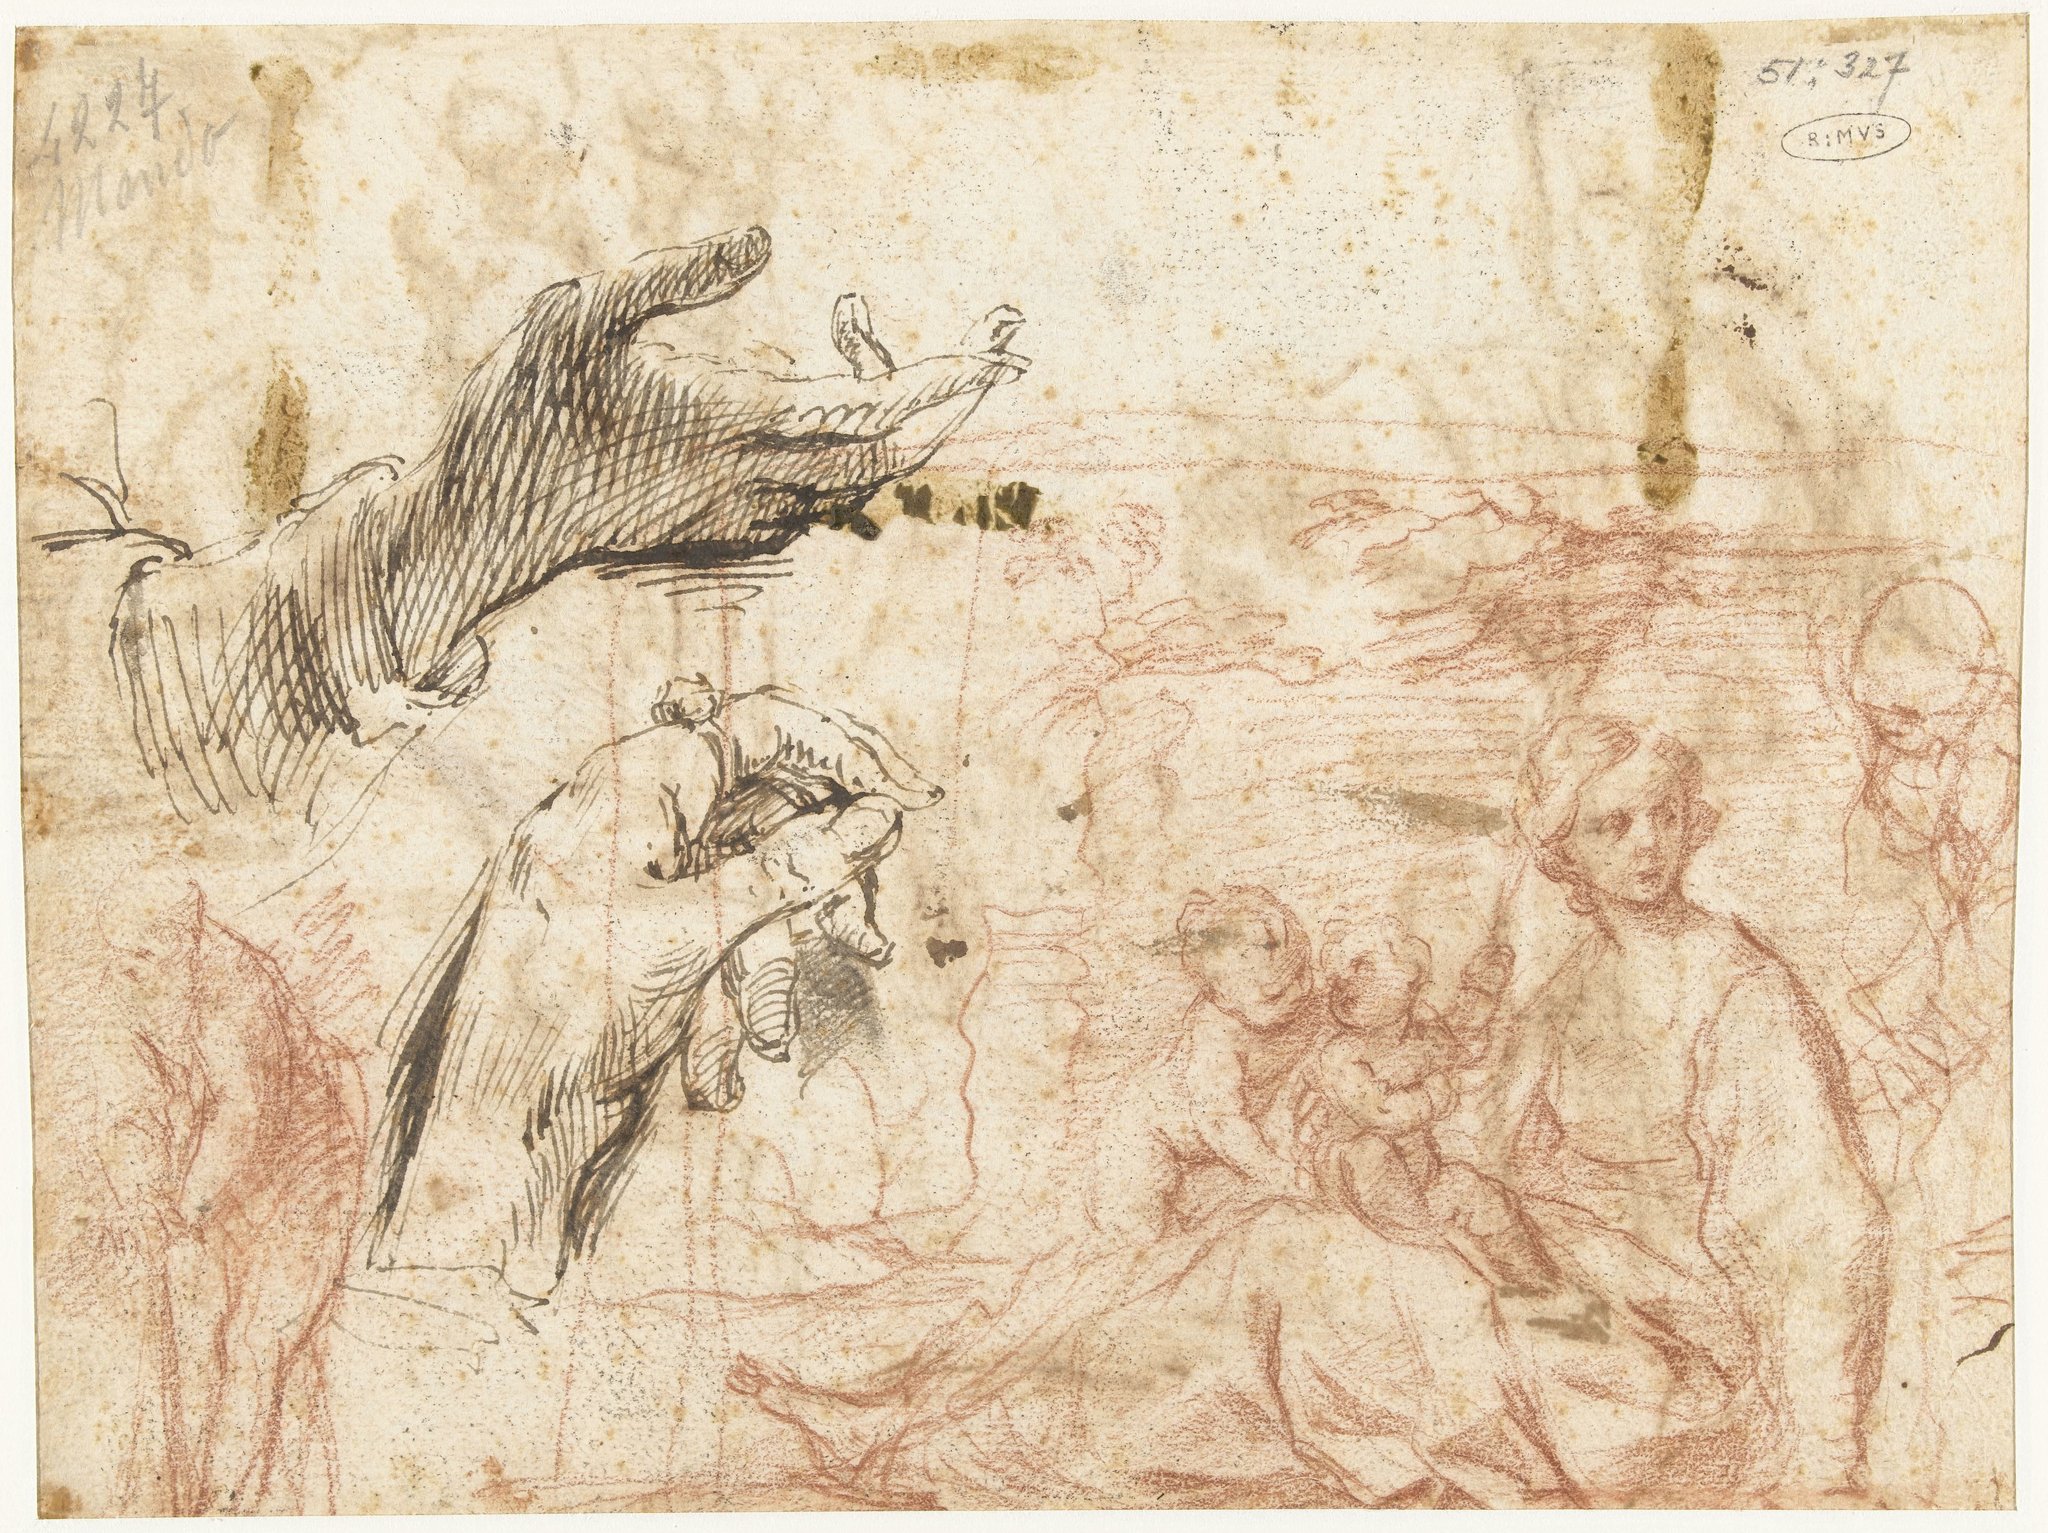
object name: drawing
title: Schetsblad met verschillende composities, onder andere van twee handen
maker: simone cantarini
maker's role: draughtsman, print maker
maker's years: 1612-1648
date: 1635-1645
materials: chalk, ink, paper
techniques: pen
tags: postures and gestures of hand and fingers, mary and the christ-child with john the baptist (as child)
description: Verschillende composities, waaronder twee handen en een Rust op weg naar Egypte.